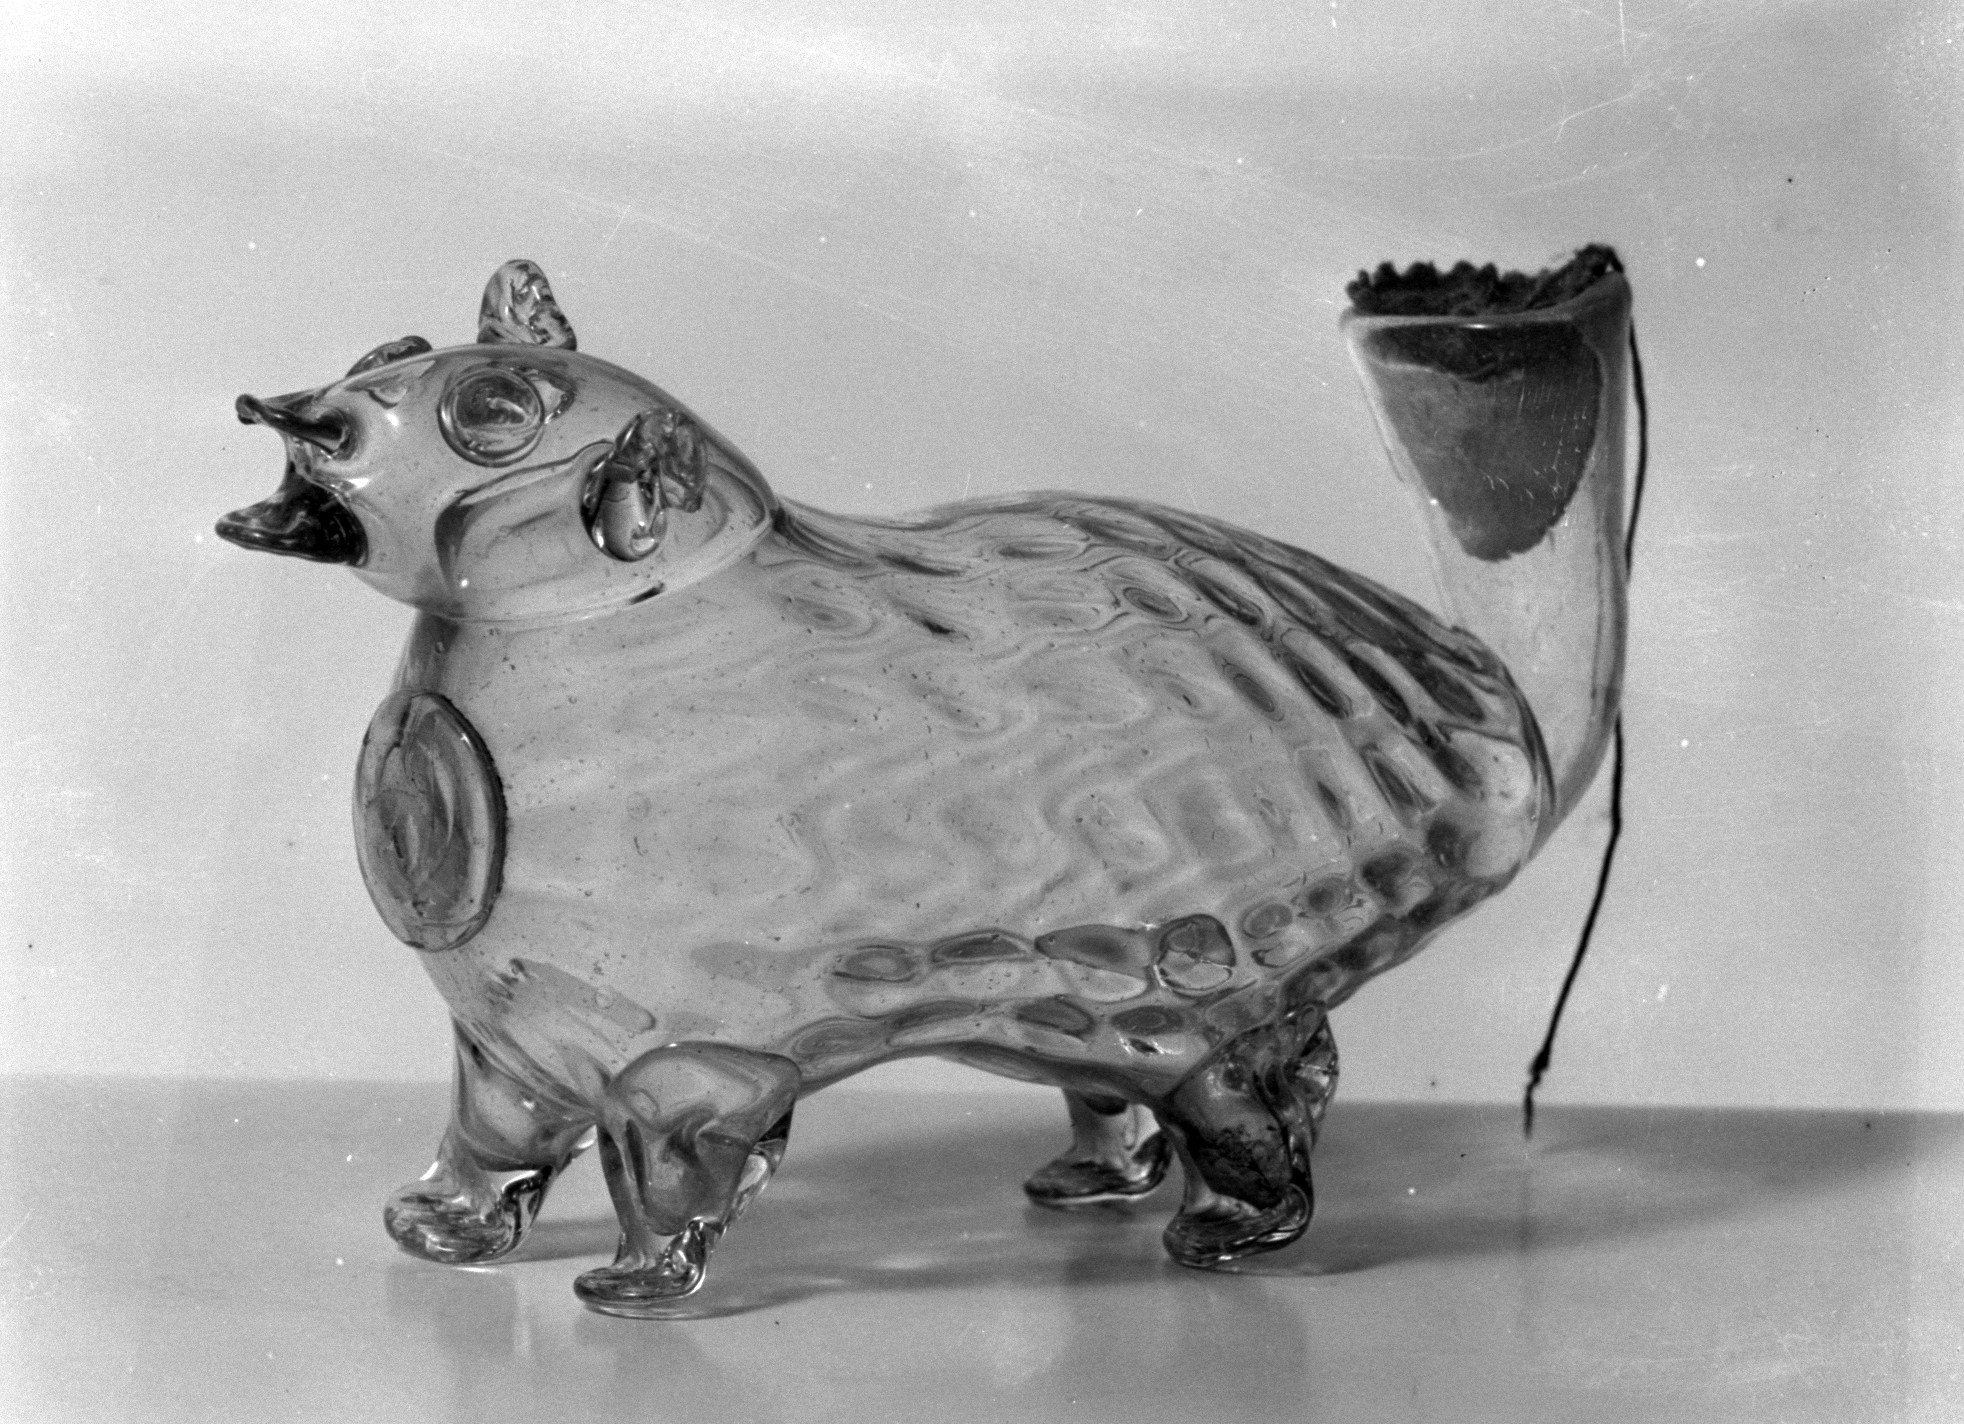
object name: oil lamp or pitcher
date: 1601-1800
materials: glass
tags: animals